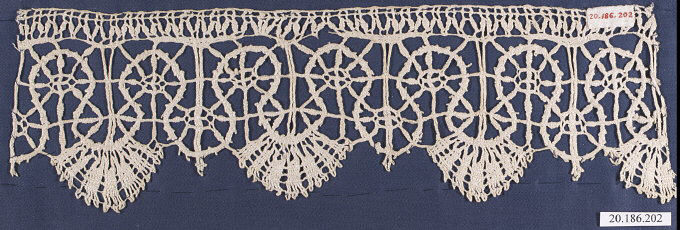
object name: edging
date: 1601-1700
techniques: lace